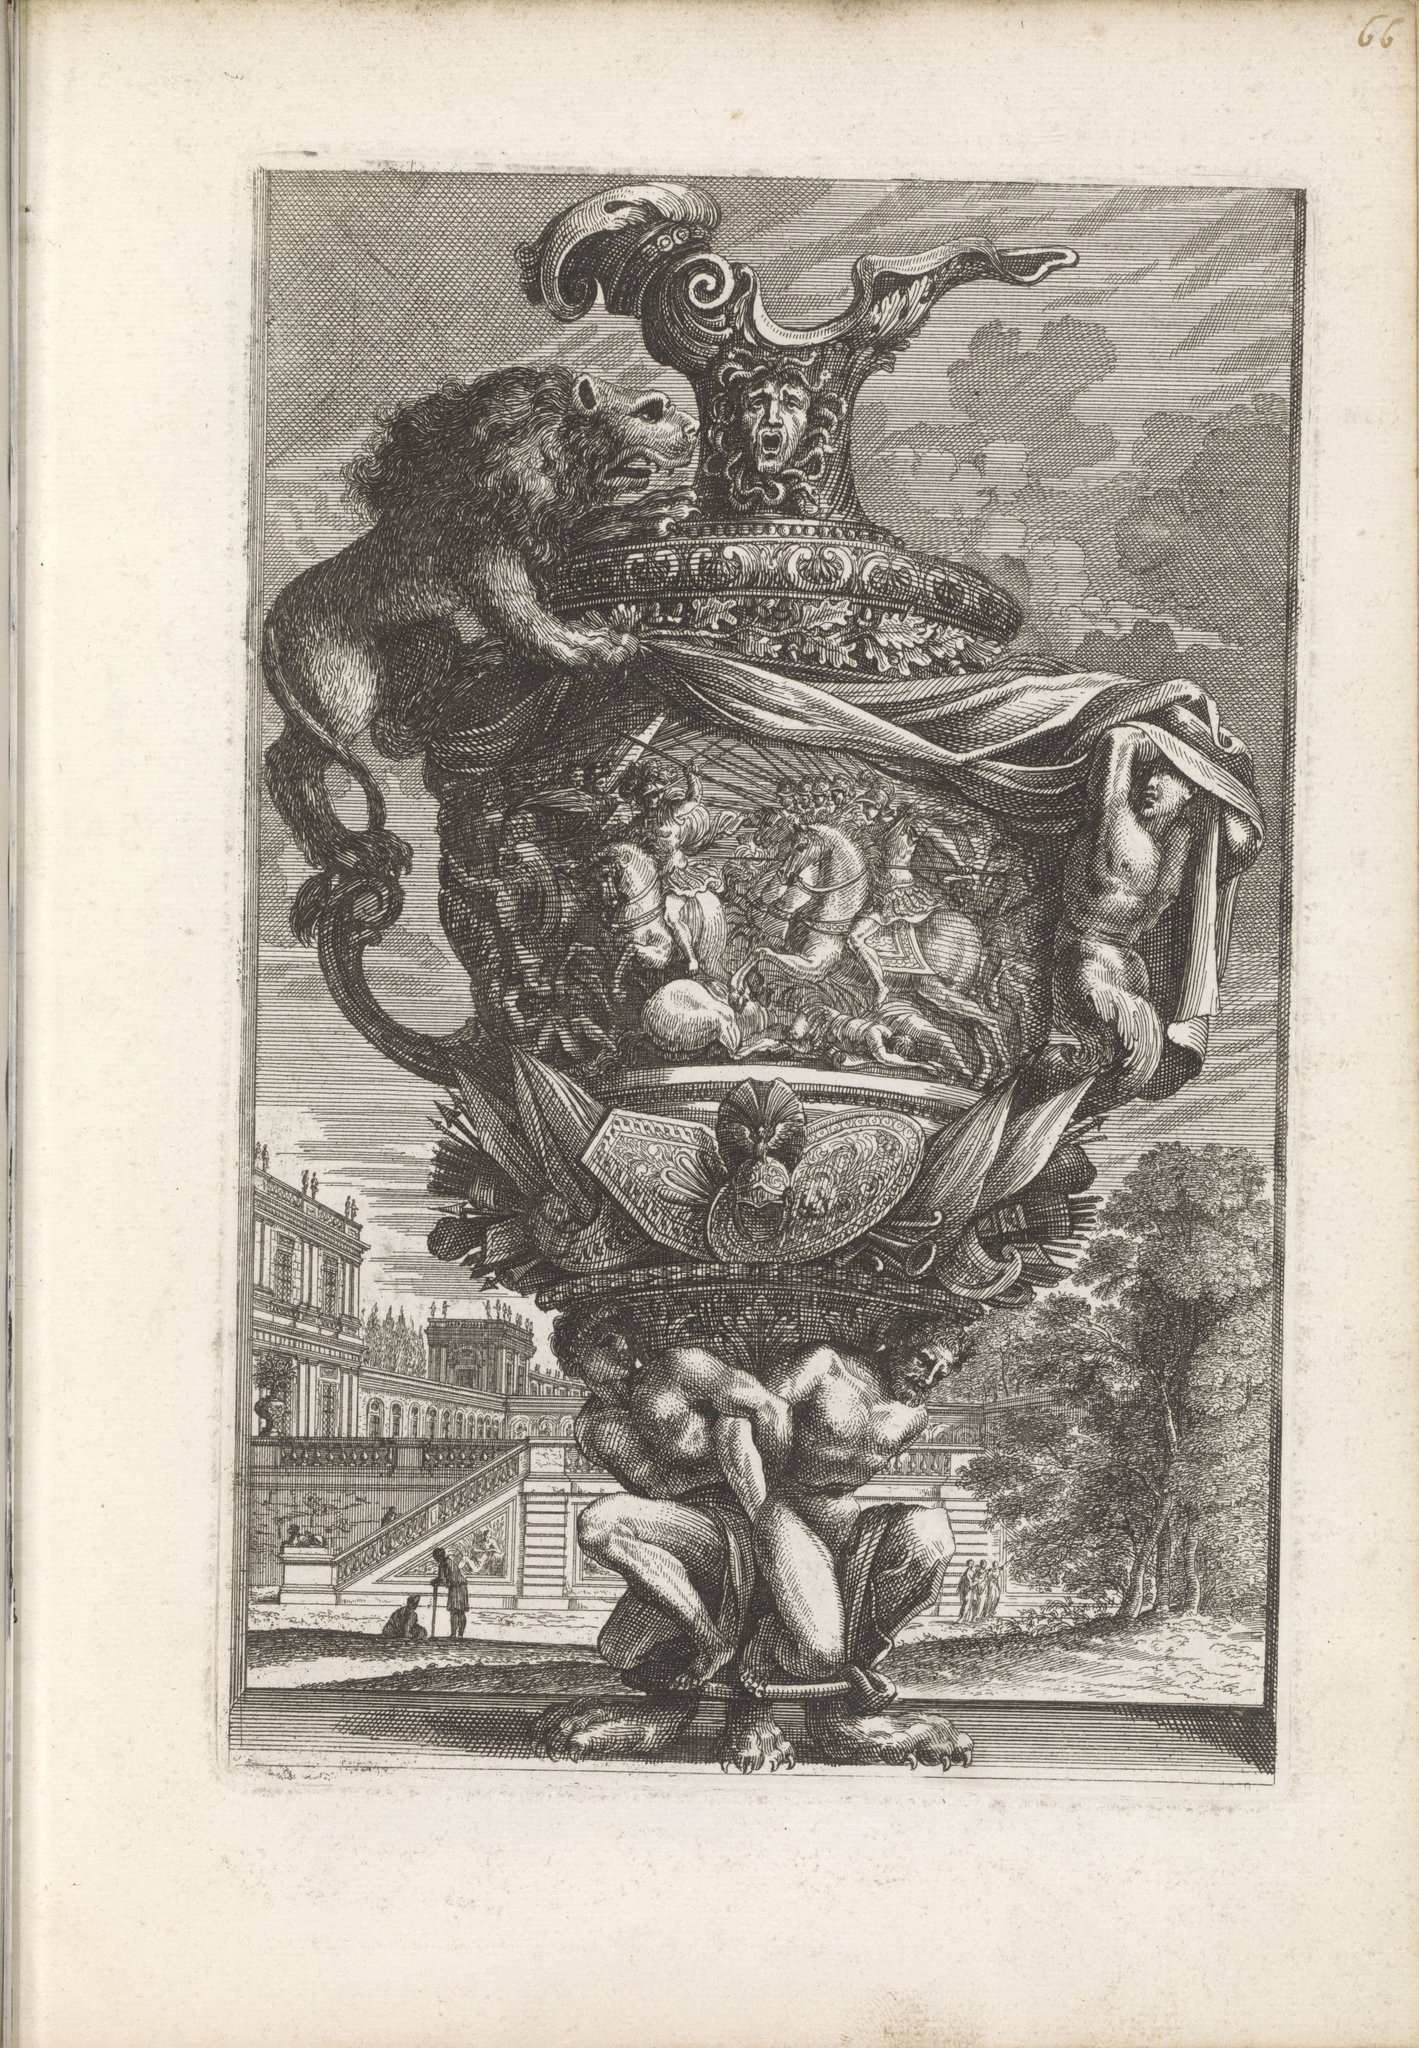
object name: album leaf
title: Schenkkan met een leeuw als handvat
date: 1659-1678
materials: paper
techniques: etching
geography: antwerp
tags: ornaments ~ art, slavery; serfs and enslaved persons, classical mythology and ancient history, beasts of prey, predatory animals: lion, prisoner of war (after the battle), container of precious metal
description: De kan heeft een voet in de vorm van twee vastgebonden krijgsgevangenen of slaafgemaakte mannen, het handvat wordt gevormd door een leeuw die op een console staat. Kopie naar een prent in de serie Vases à la moderne. Prent maakt deel uit van een album.